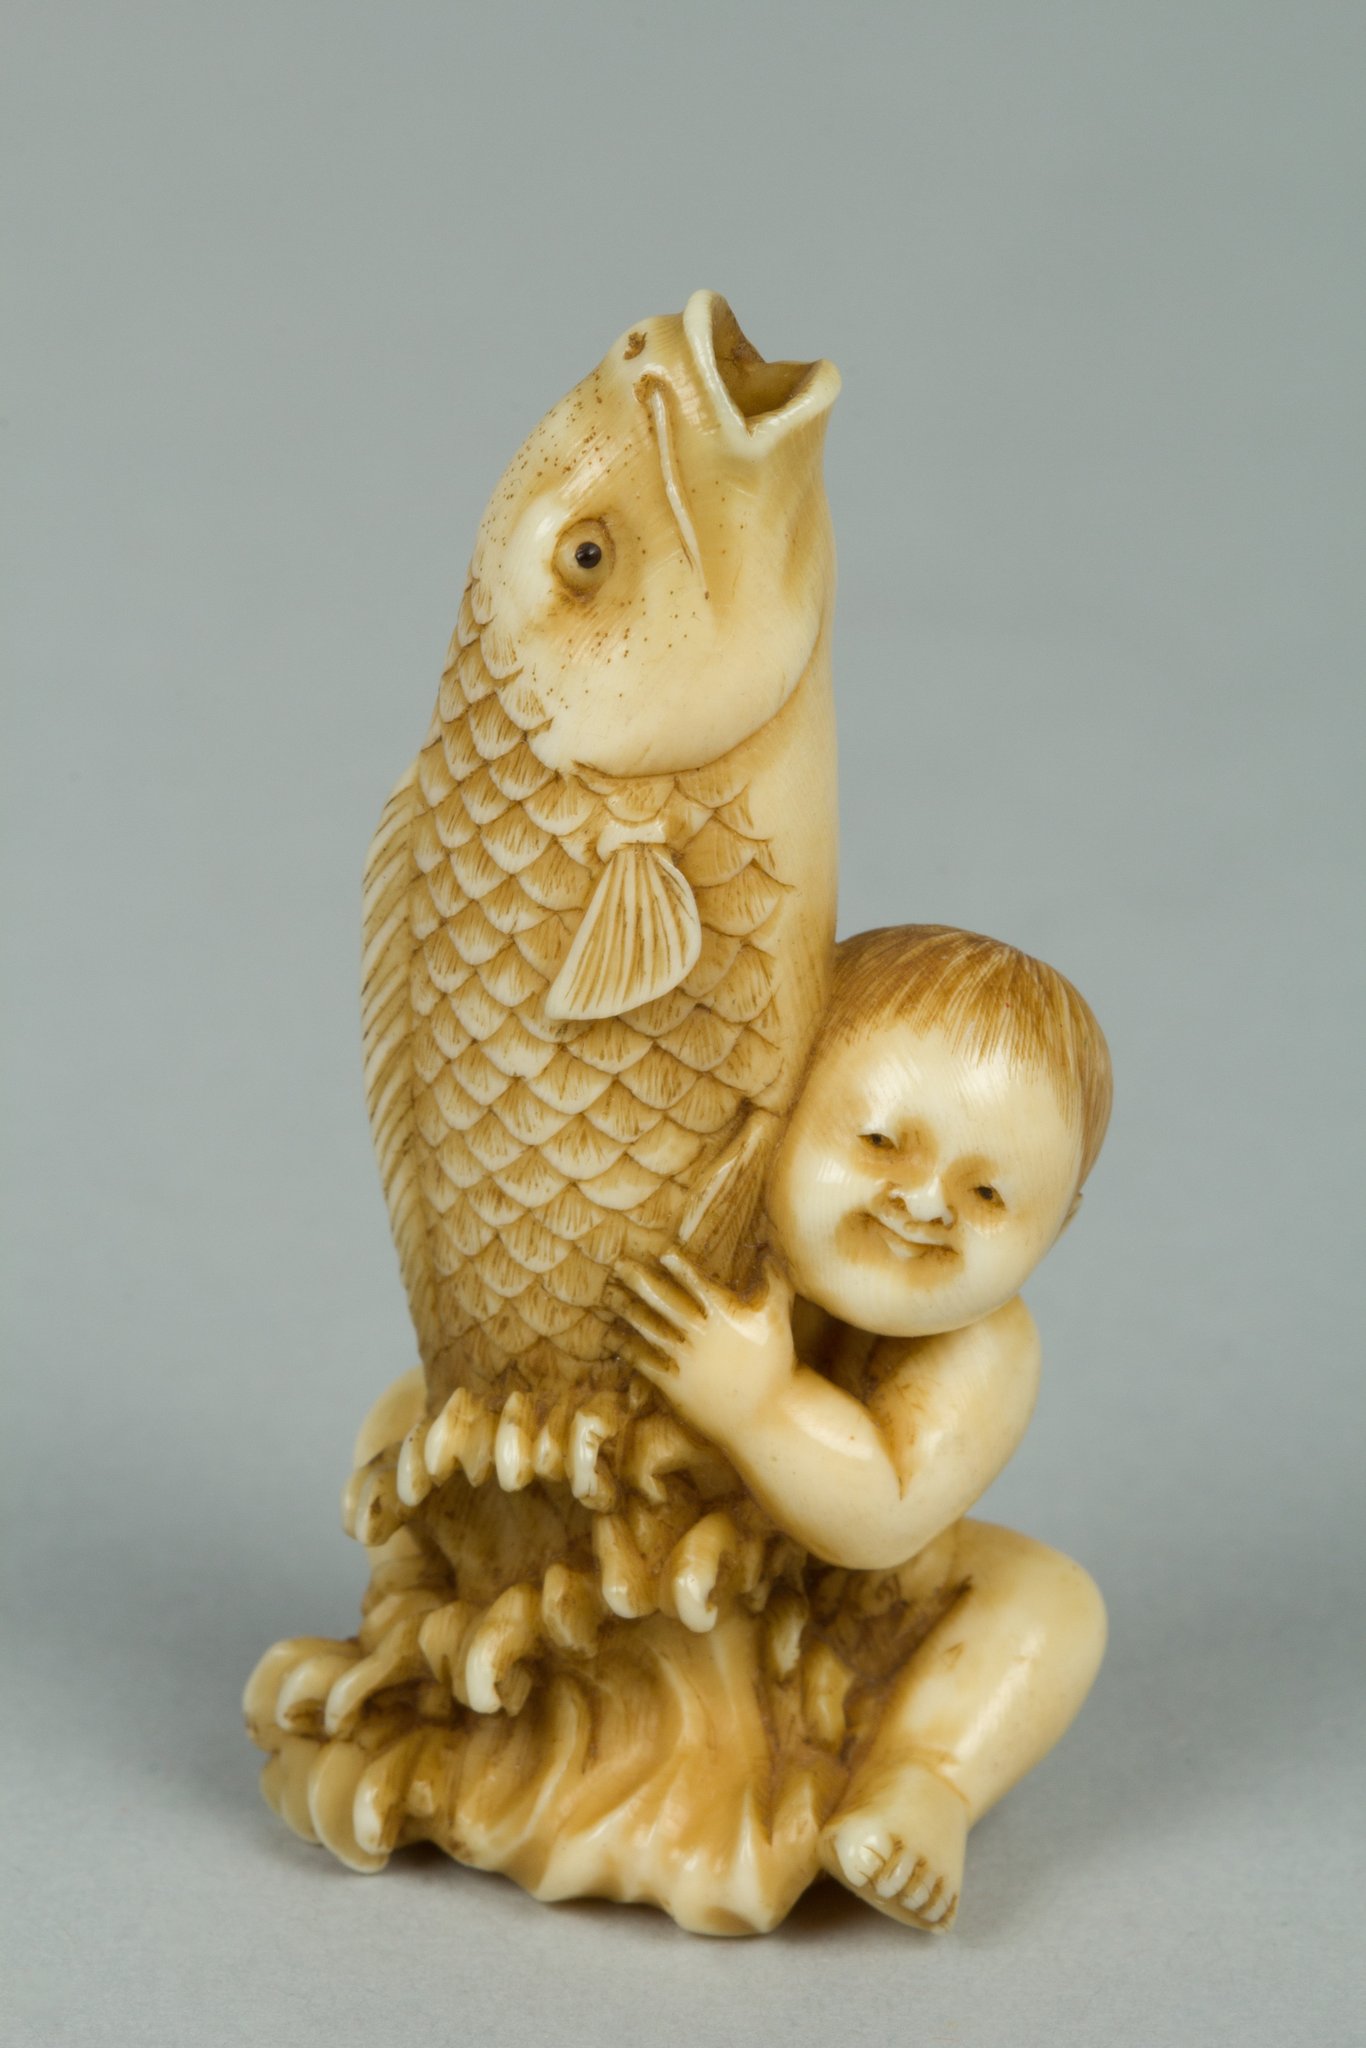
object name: netsuke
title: Netsuke of Child with a Carp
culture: japanese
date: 1801-1900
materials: ivory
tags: children